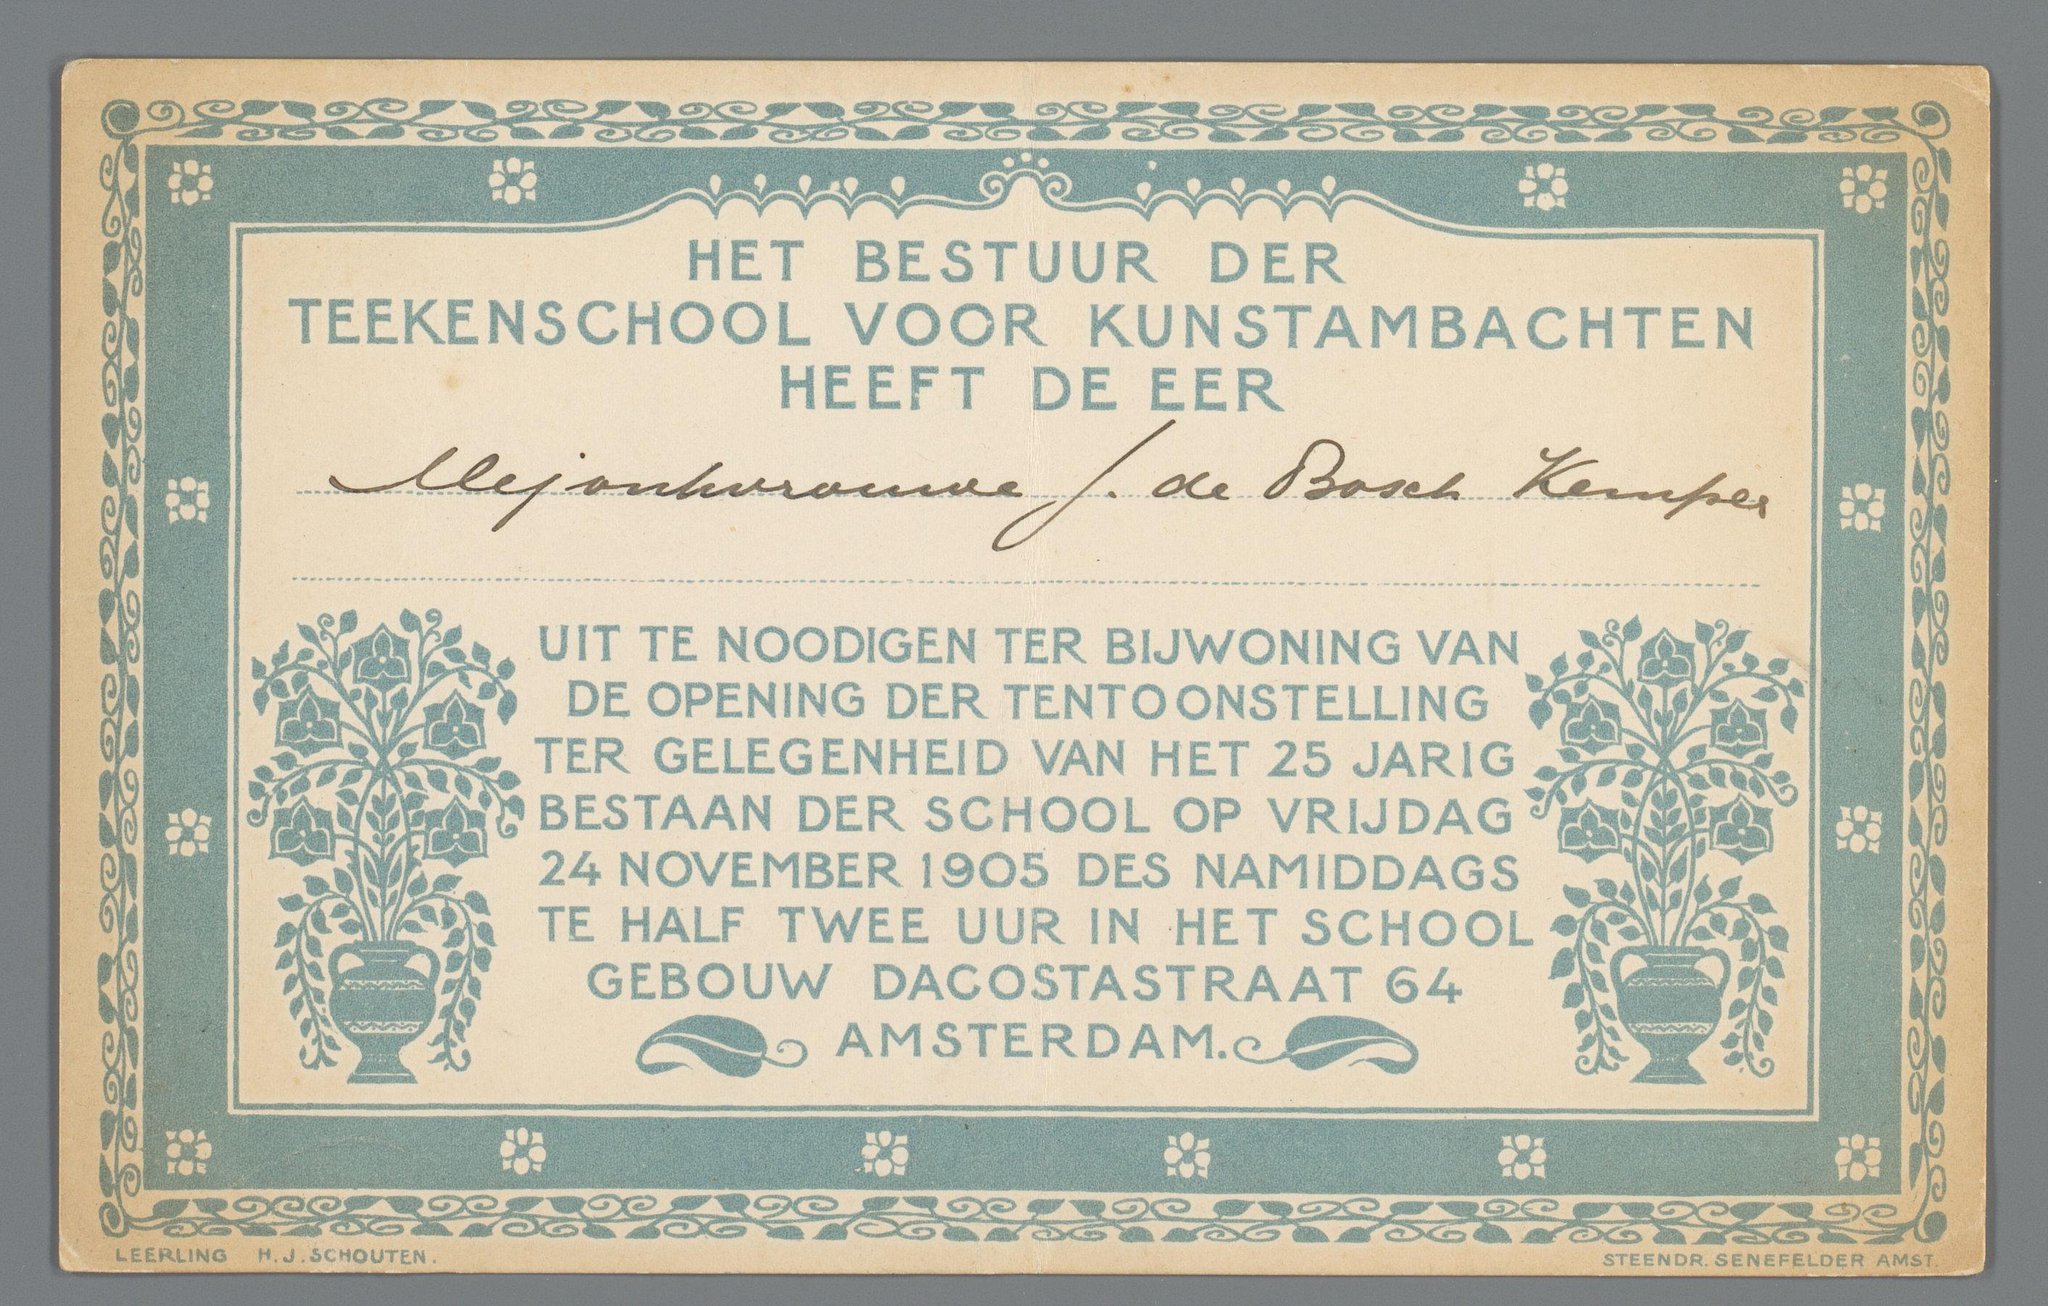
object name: invitation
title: Uitnodiging voor de opening van de tentoonstelling ter ere van het vijfentwintigjarig jubileum van de Teekenschool voor Kunstambachten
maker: h.j. schouten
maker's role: draughtsman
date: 1905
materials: paper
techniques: lithograph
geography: amsterdam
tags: amsterdam, collection, exhibition, show, ornament derived from plant forms, garden vase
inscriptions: inscription: ‘Mejonkvrouwe J. de Bosch Kemper’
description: Een decoratief kader en twee vazen met bloeiende planten. Uitnodiging gericht aan jonkvrouw Jeltje de Bosch Kemper voor een opening op 24 november 1905 in de Teekenschool voor Kunstambachten in Amsterdam. De naam is met de hand geschreven.